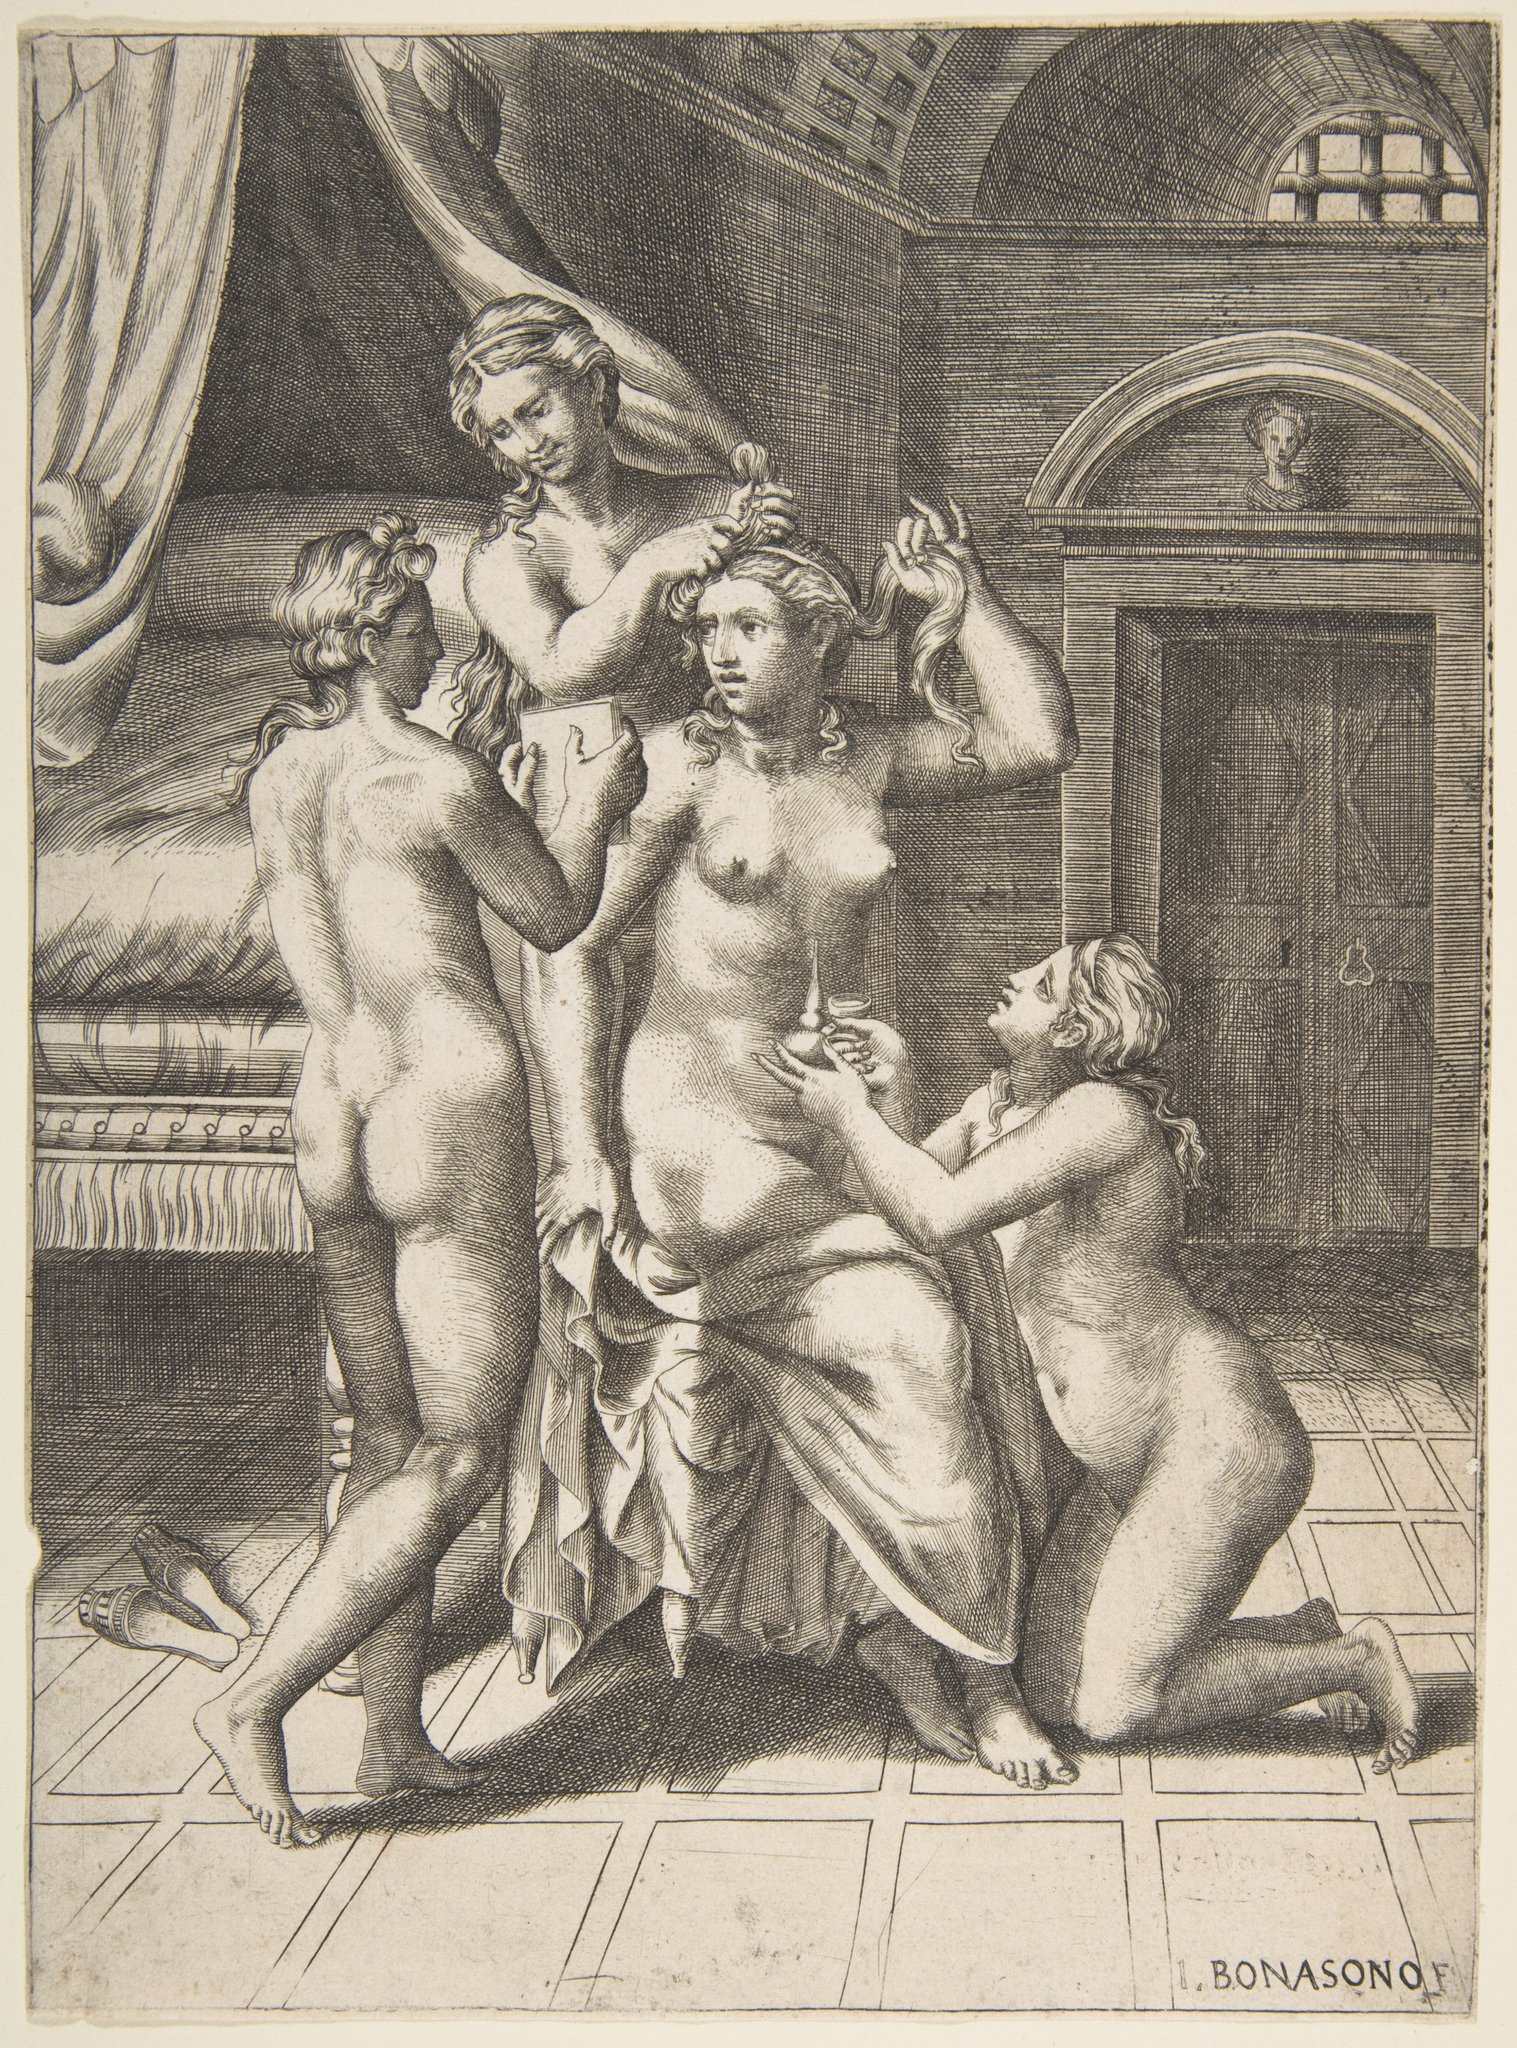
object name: print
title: The toilet of Psyche who is seated in the centre being attended to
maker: giulio bonasone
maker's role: artist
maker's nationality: italian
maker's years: 1510-1576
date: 1531-1576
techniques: engraving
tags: female nudes,psyche